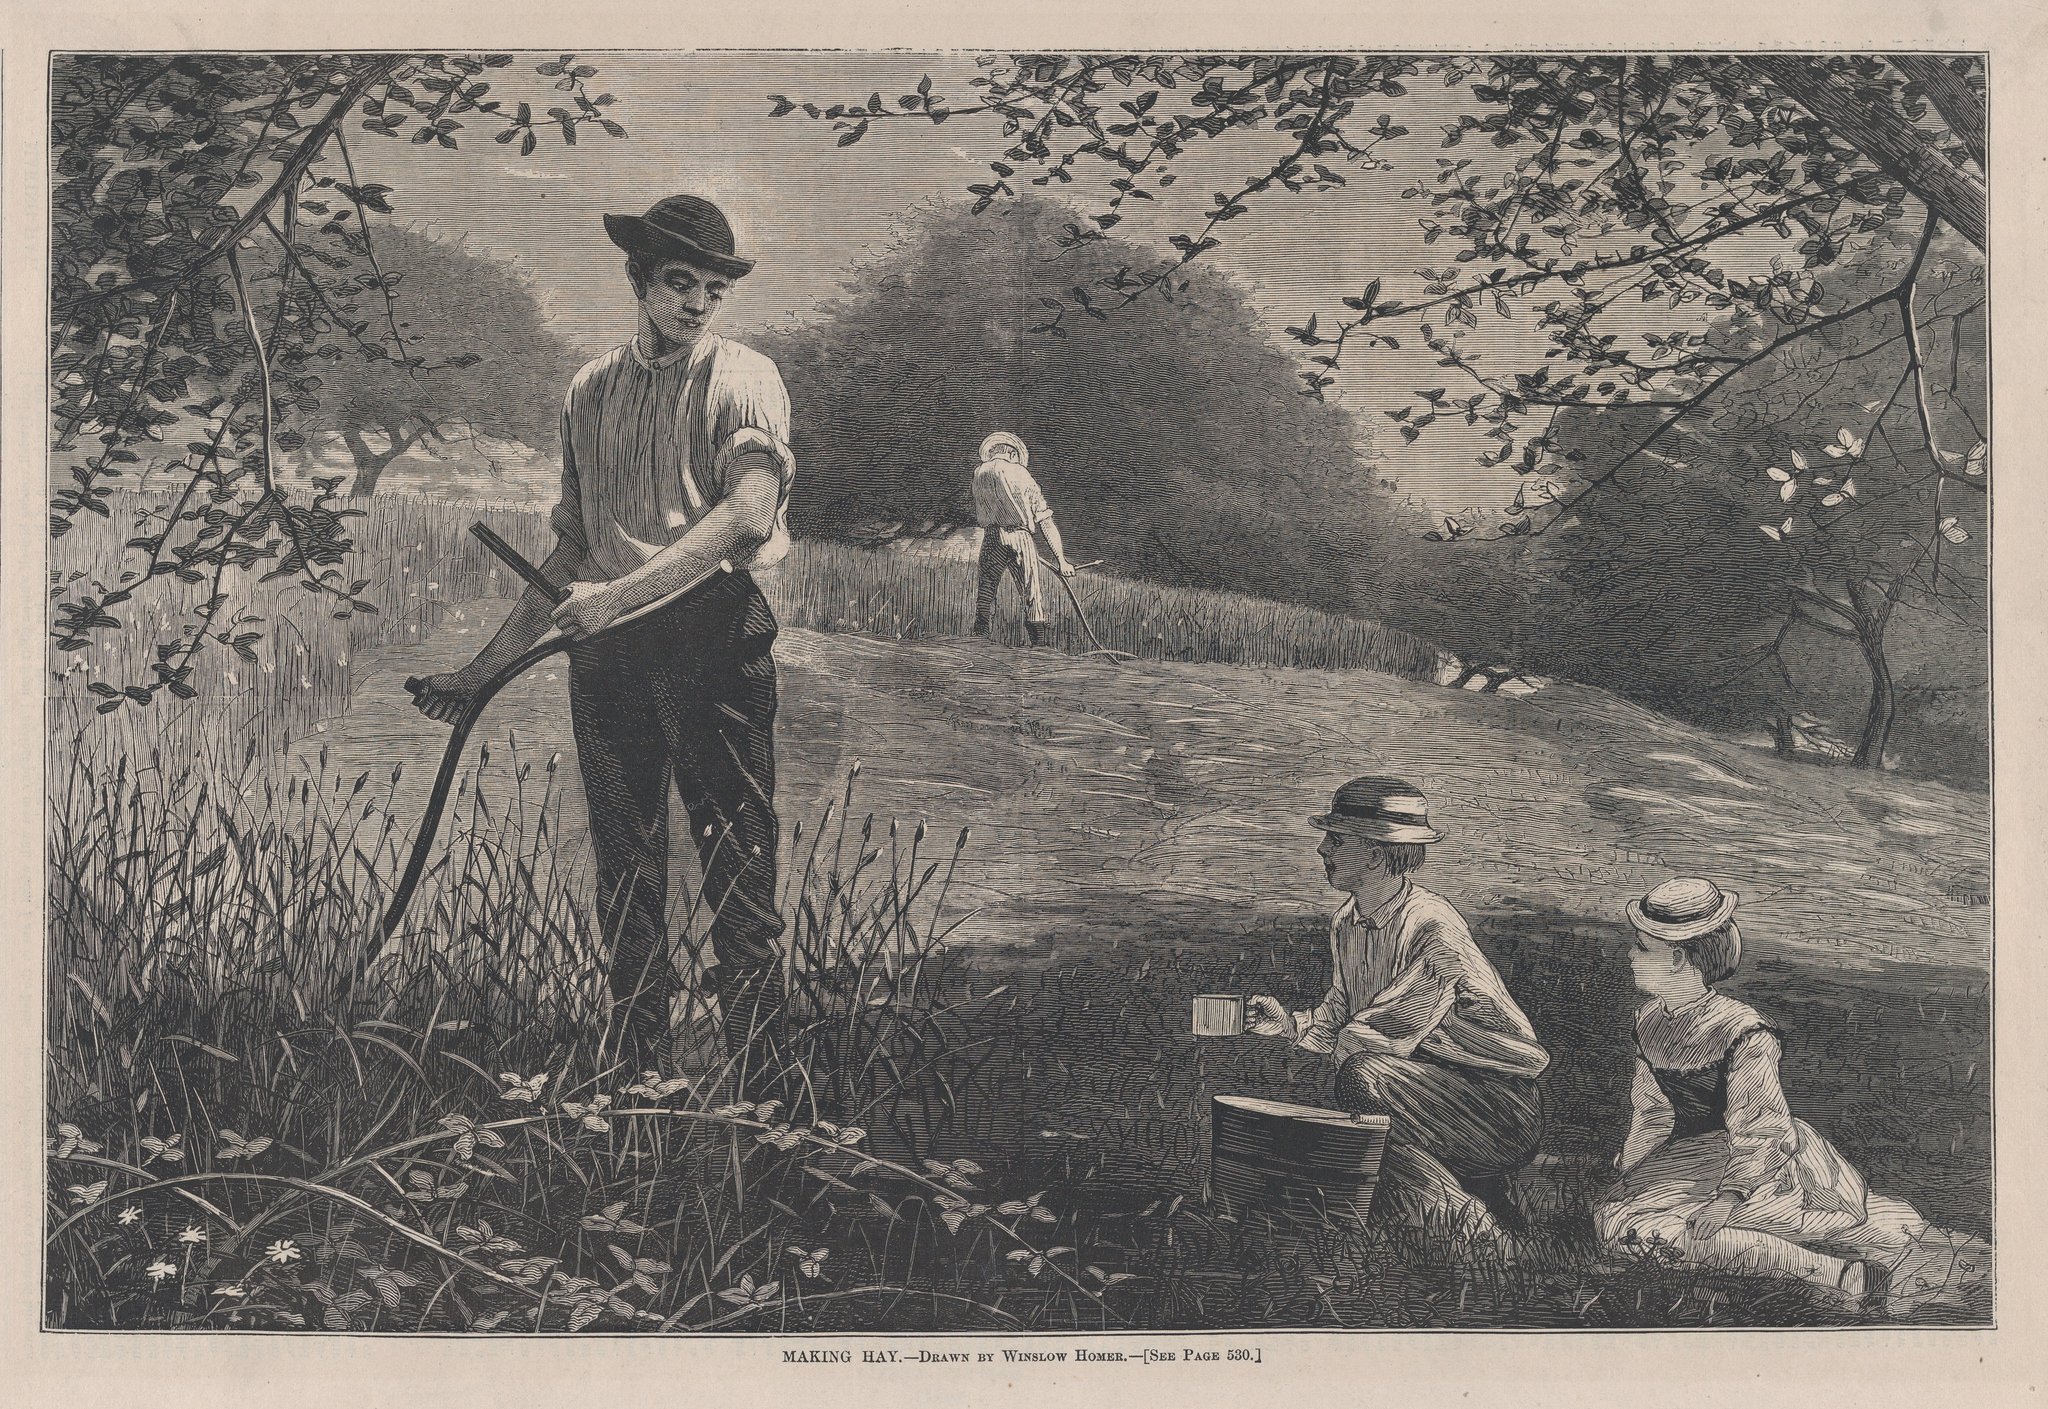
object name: print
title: Making Hay, from "Harper's Weekly," Vol. XVI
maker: winslow homer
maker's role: artist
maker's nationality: american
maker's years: 1836-1910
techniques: engraving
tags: boys,girls,men,working